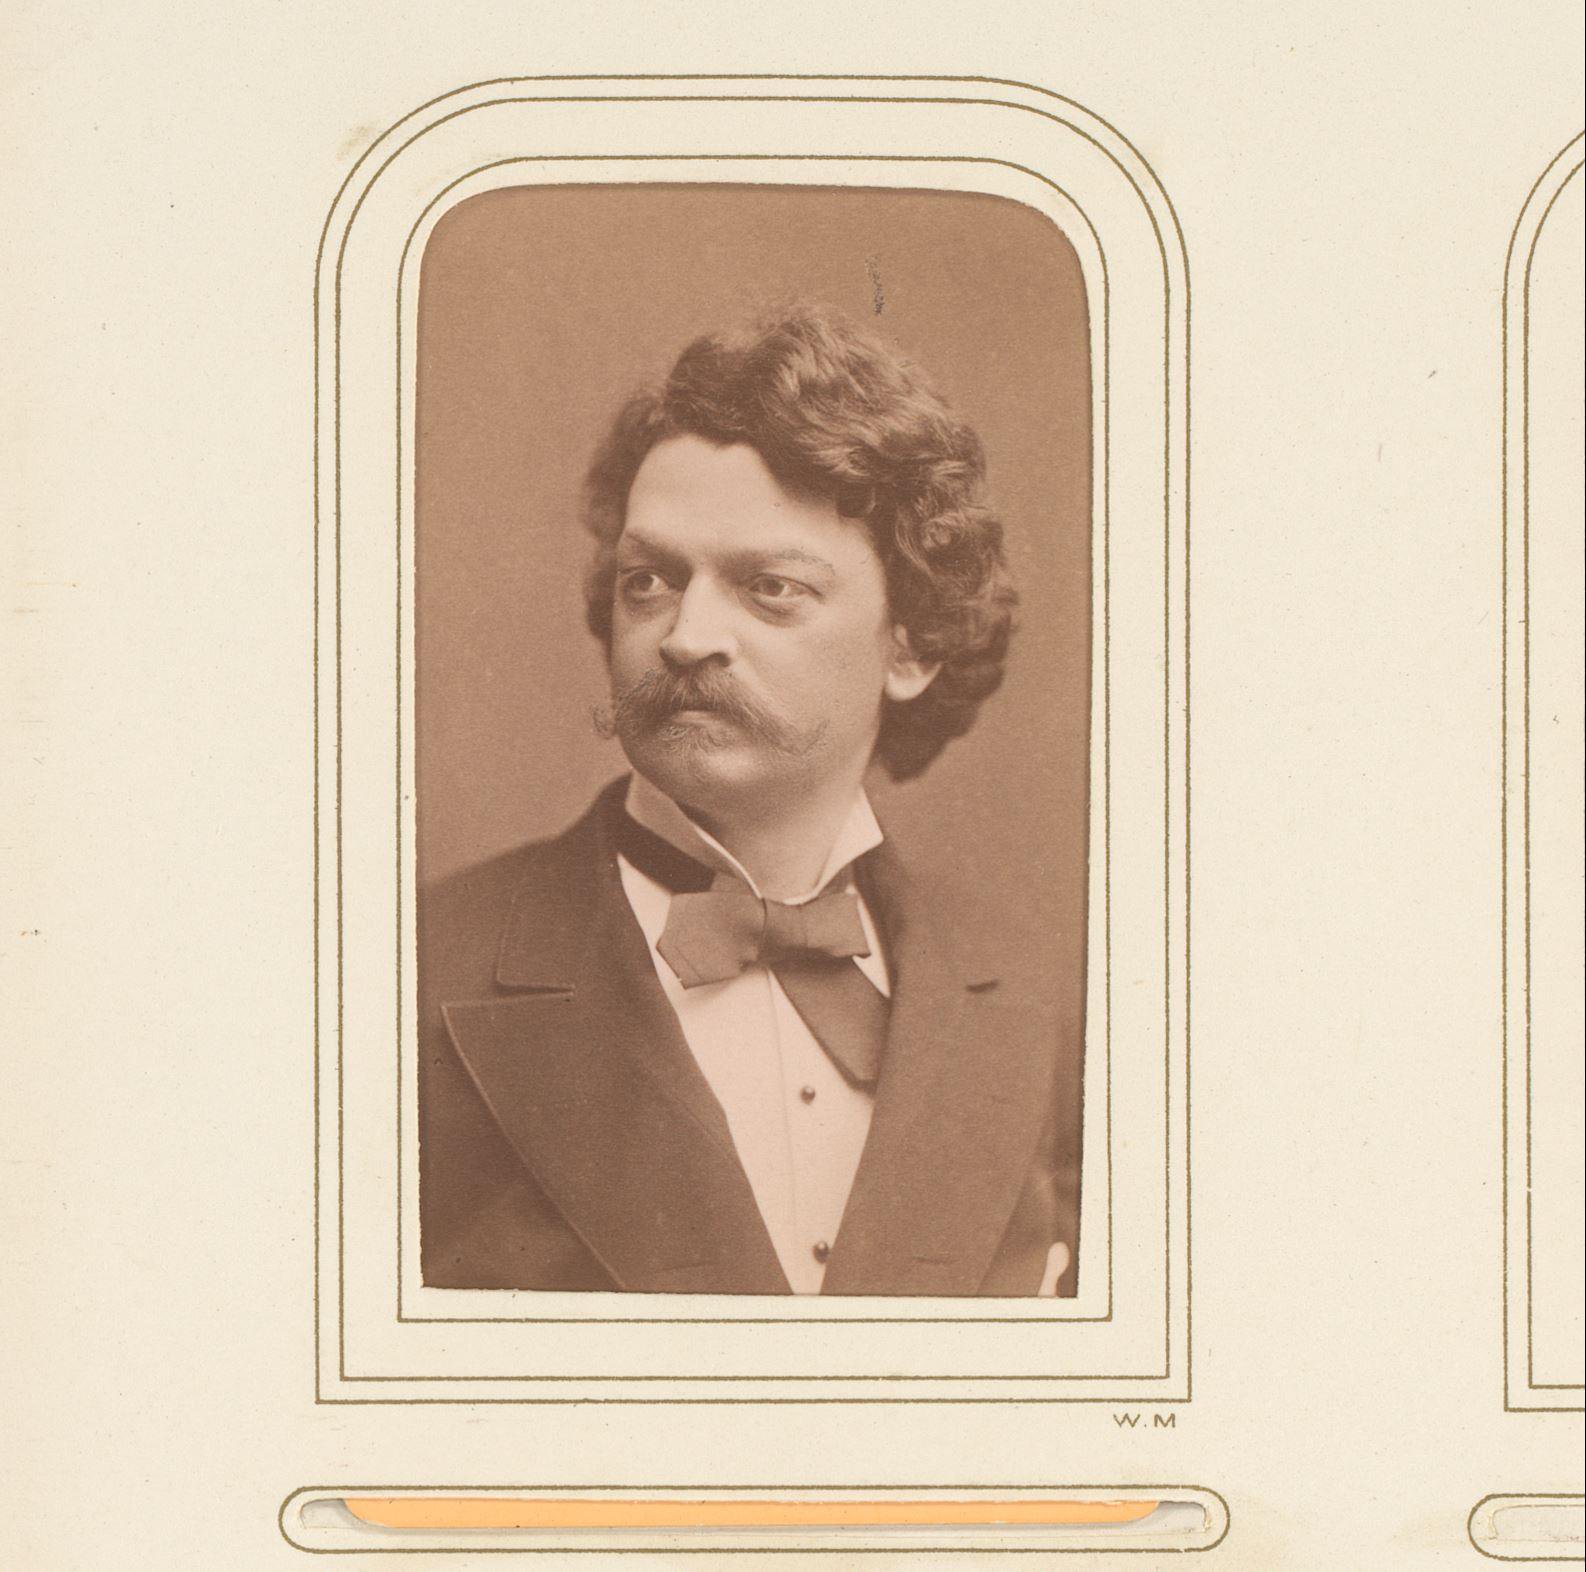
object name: carte de visite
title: Portret van Axel Elmlund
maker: gösta florman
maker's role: fotograaf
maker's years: 1831-1900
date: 1865-1885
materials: cardboard, photographic support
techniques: albumen print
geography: stockholm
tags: historical persons, portrait of actor, actress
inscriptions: annotation: ‘Axel Elmlund/ 1838 - 1901’, inscription: ‘Gösta Florman/ STOCKHOLM/ 28A Regeringsgatan 28 A.’